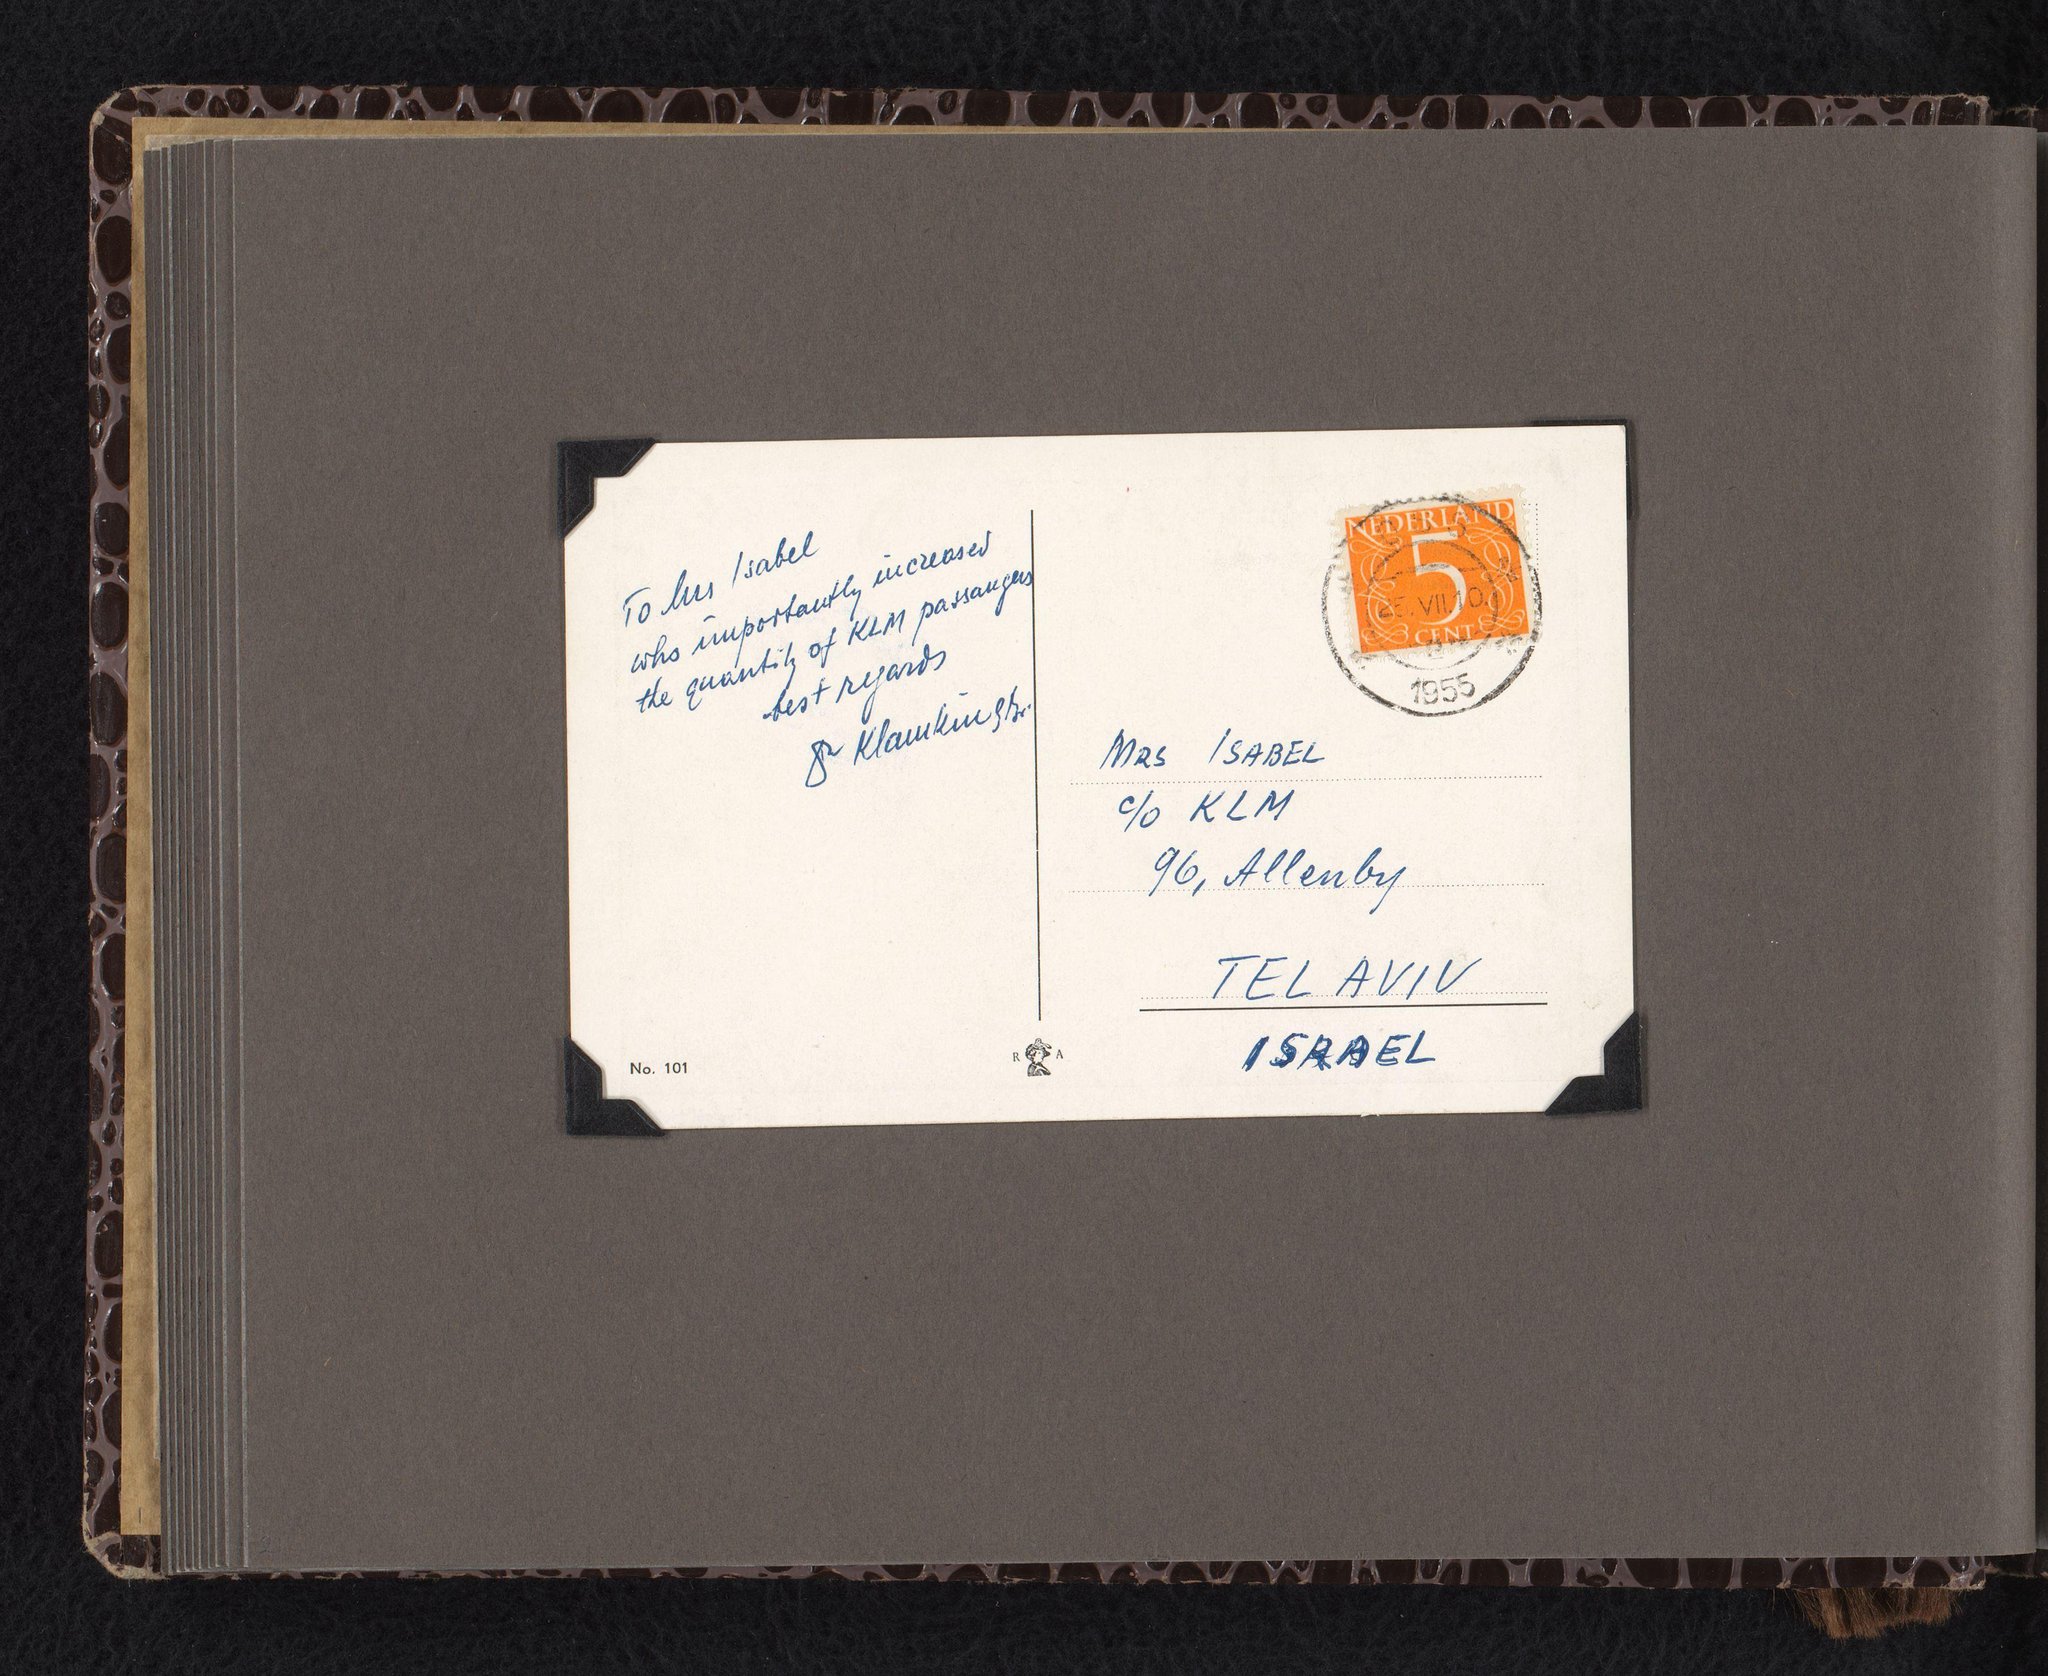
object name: ansichtkaart, prentbriefkaart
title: Prentbriefkaart met bedankje aan Isabel Wachenheimer voor haar goede zorgen voor de passagiers van KLM tijdens de periode dat Isabel werkzaam was als medewerker van de KLM in Israël, 1955, Tel-Aviv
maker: Anonymous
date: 1955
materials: paper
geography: netherlands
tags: isabel wachenheimer-elon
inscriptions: inscription: ‘To Mrs Isabel who importantly increased the quality of KLM passengers best regards (onleesbaar) Mrs Isabel c/o KLM 96, Allenby Tel Aviv Israël’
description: Blad bevat één gefrankeerde en beschreven prentbriefkaart van een tekening 'Typical Holland' met op achterzijde een bedankbriefje. Verstuurd vanuit Nederland in 1955. Uit album half formaat, kunstlederen omslag met koordbinding.